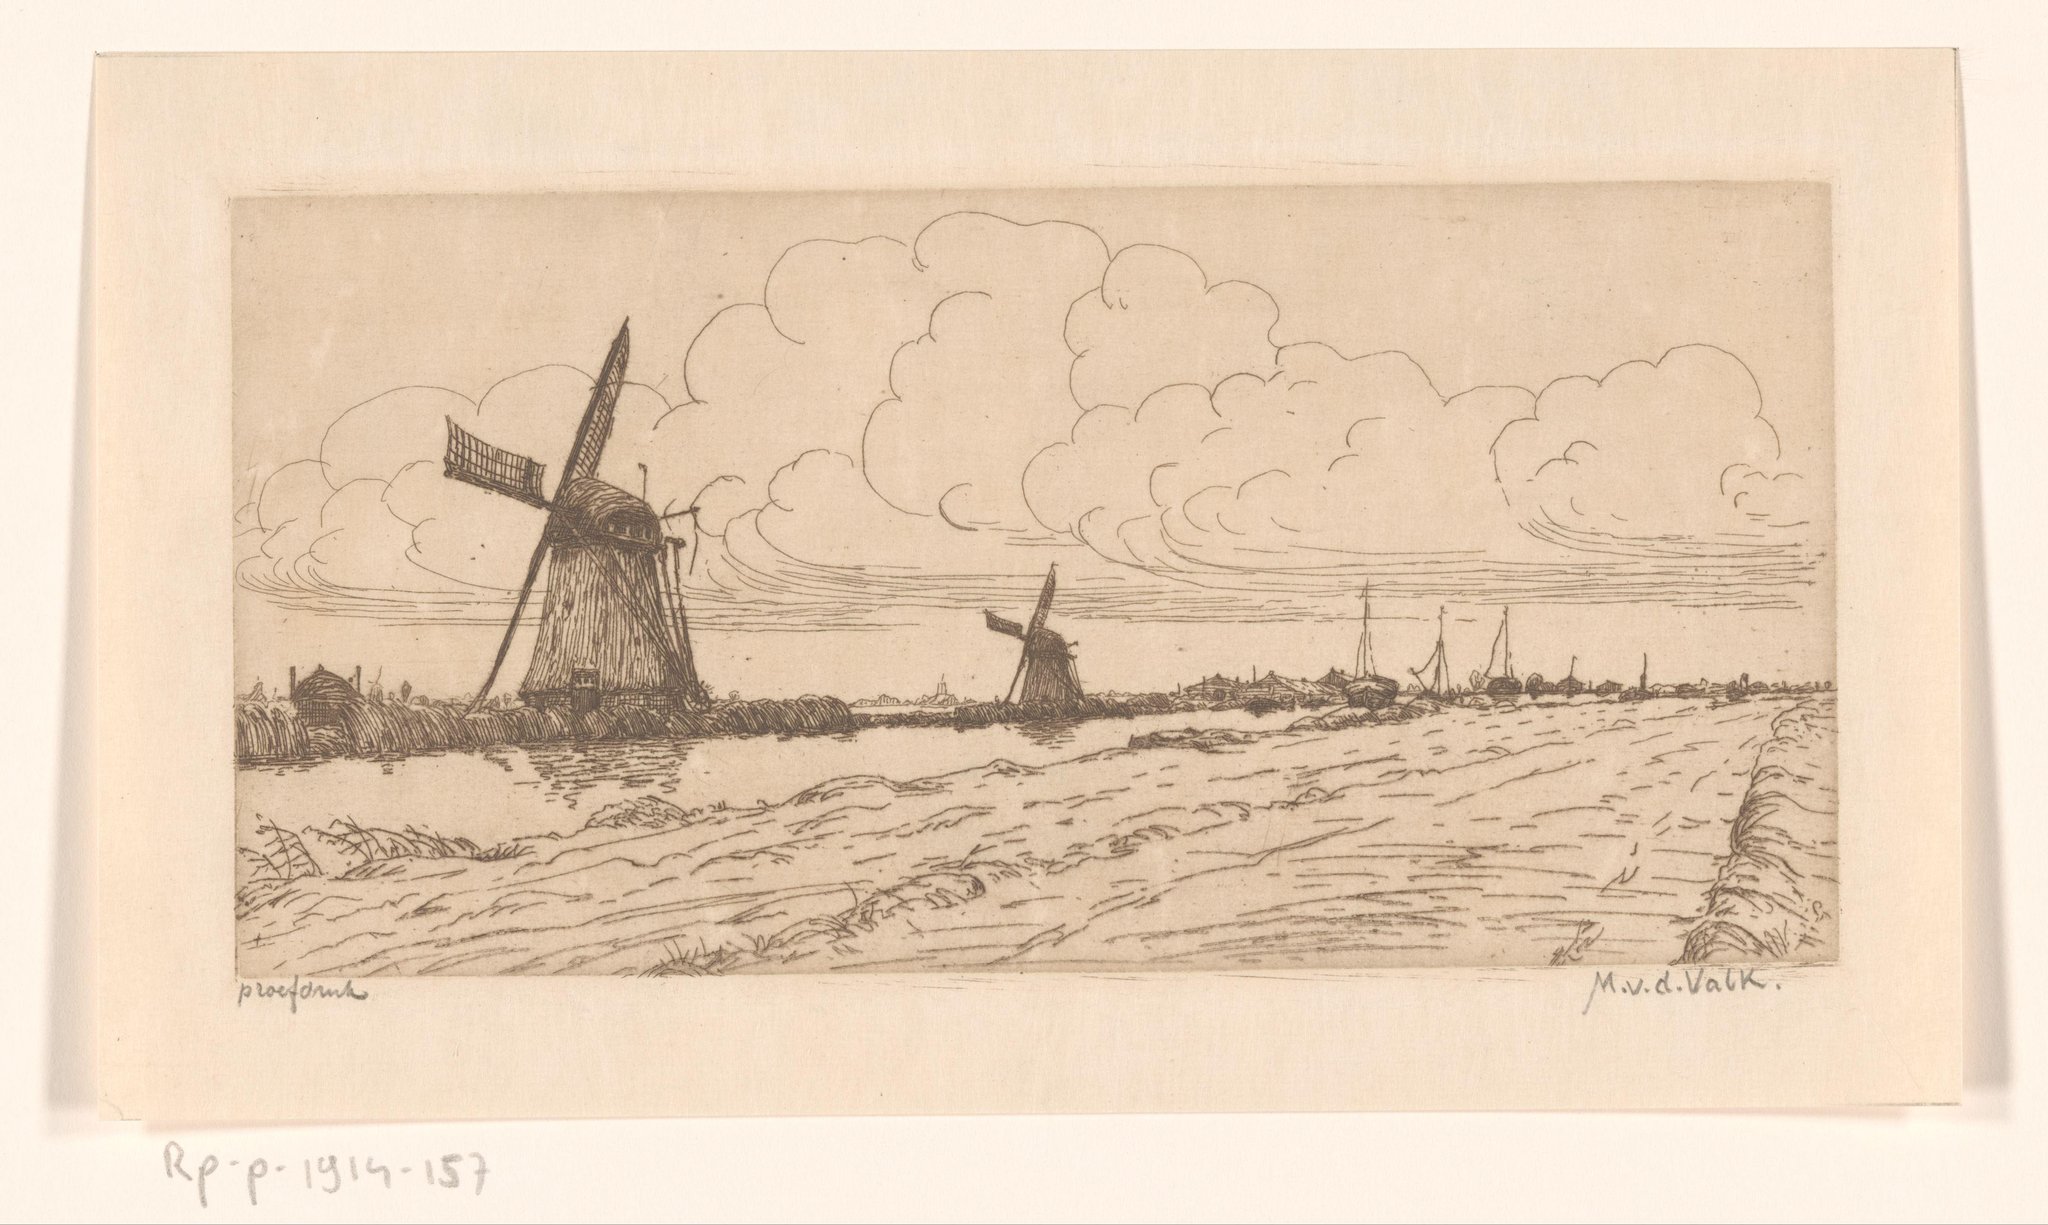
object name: print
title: Landschap met weiland, kanaal en molens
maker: maurits van der valk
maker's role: draughtsman, print maker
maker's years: 1857-1935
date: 1867-1914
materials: paper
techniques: etching, intaglio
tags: meadow, pasture, canal, windmill in landscape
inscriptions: collector's mark: Lugt 2233